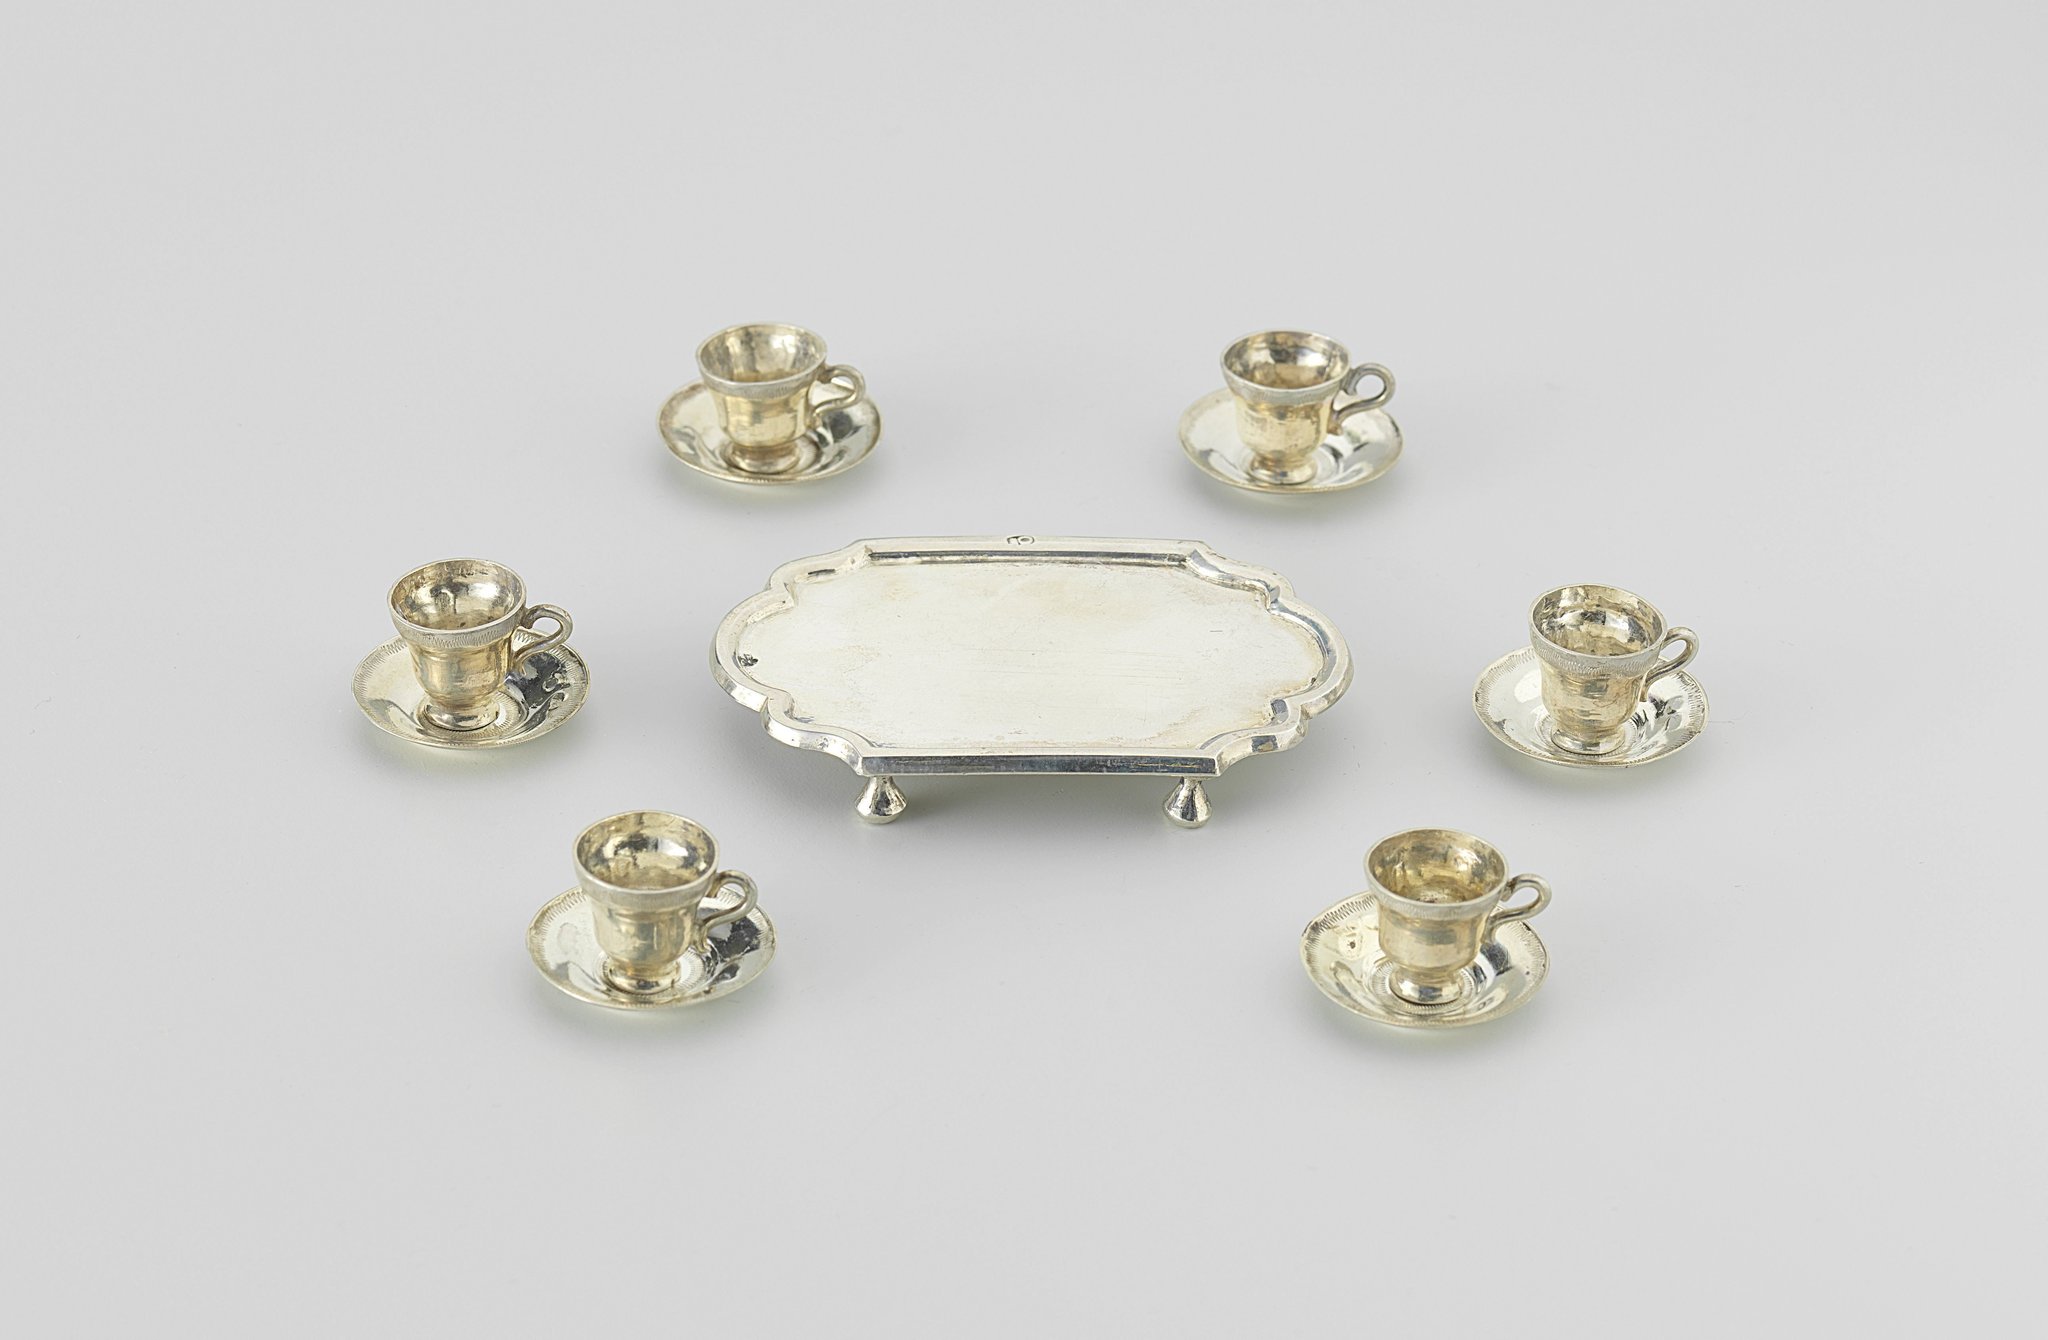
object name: miniature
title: Blad met zes kop-en-schotels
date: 1738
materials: silver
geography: amsterdam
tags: salver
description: Langwerpig dienblad met een geschulpte, verdikte rand. Het blad staat op vier kegelvormige poten. Bij het blad worden zes identieke kop en schotels bewaard. Het blad is gemerkt: stk.= Amsterdam, jrl.= D (1738), mt.= Willem van Strant, een gekroonde O en een bijltje. De koppen staan op een voet en hebben een oor. Langs de rand van de koppen, op het plat en langs de rand van de schotels is een zig-zag lijn gegraveerd. De kop en schotels zijn gemerkt: mt.= C.E. Held en een zwaard.